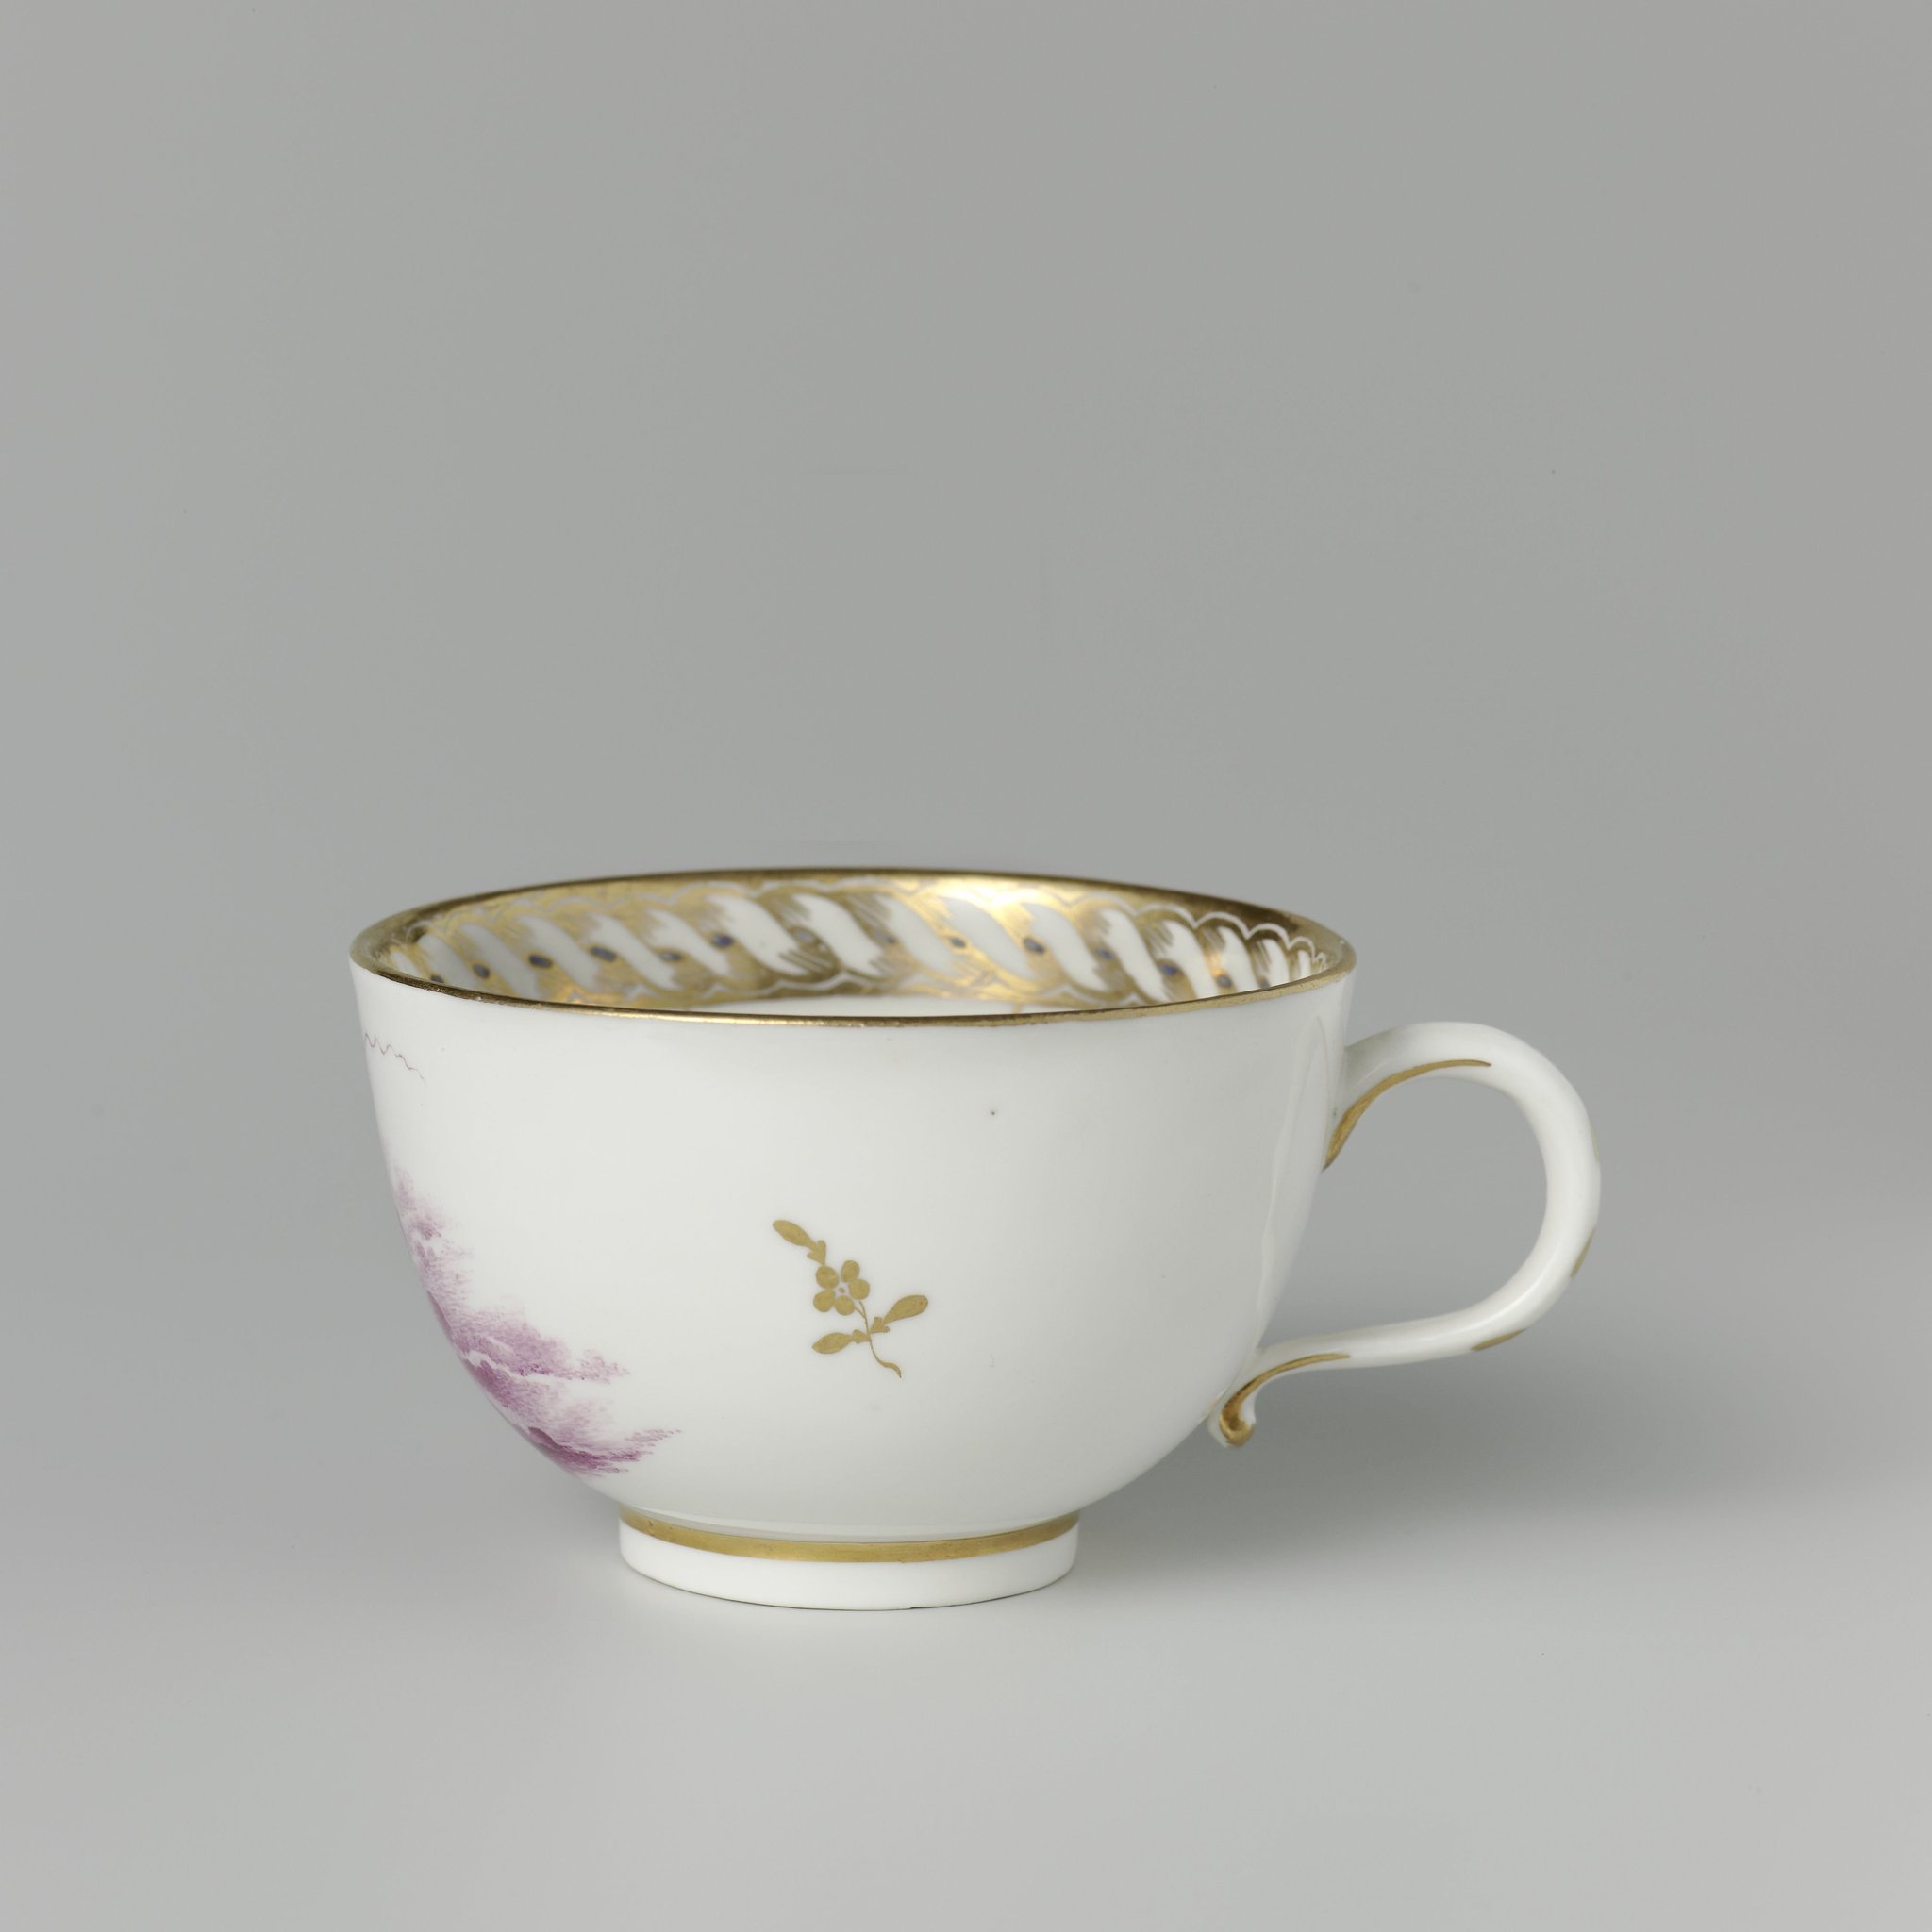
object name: cup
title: Cup with a putto on clouds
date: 1785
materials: glaze, gold, paint, porcelain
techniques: firing, forming, gilding, turning, vitrification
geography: the hague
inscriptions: mark: ‘ooievaar’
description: Kop (theekop) van porselein met een C-vormig oor, beschilderd op het glazuur in roze (camaïeu) en goud. Op de buitenwand een putto rijdend op een stokpaard op een wolk. Om de voorstelling strooibloemen in goud. De binnenrand met een gedraaide band, waaraan guirlandes en bloemtakken hangen. Gouden lijn op de voet en gouden rand. Gemerkt op de onderzijde met de ooievaar.